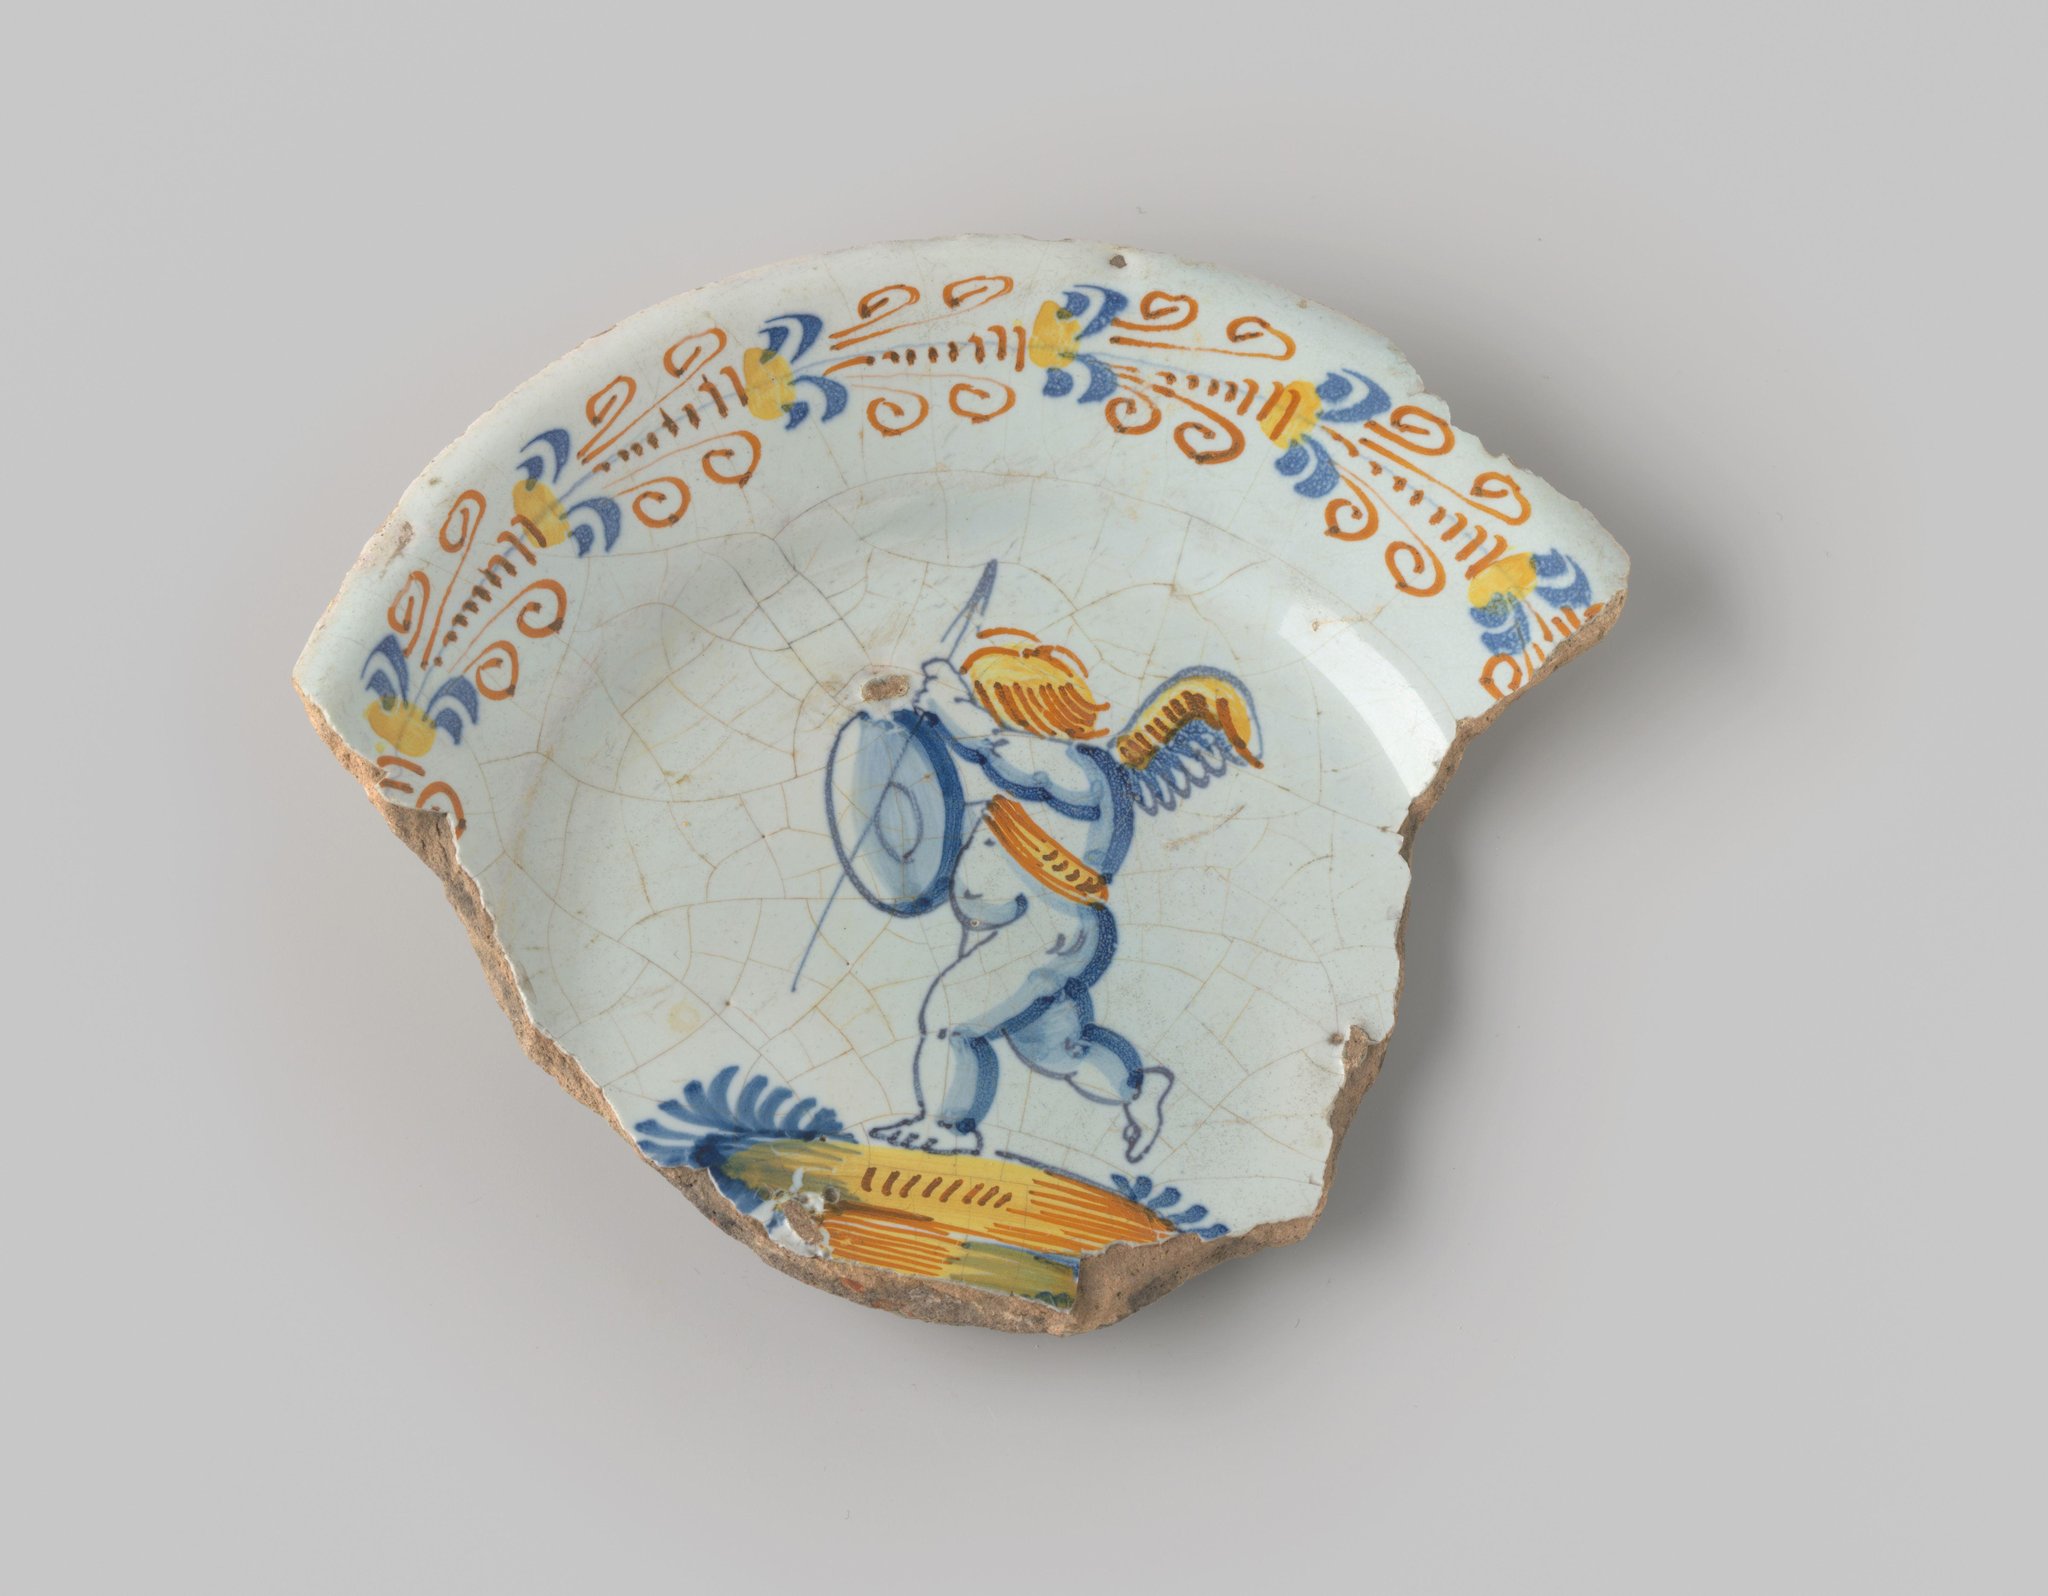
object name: sherd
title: Scherf van witbakkend aardewerk, met standring, voorzien van wit glazuur, met in het midden een afbeelding van een amor met speer en schild, en op de rand krullen, in oranje, blauw en geel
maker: Anonymous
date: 1600-1650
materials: earthenware, glaze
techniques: maiolica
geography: northern netherlands